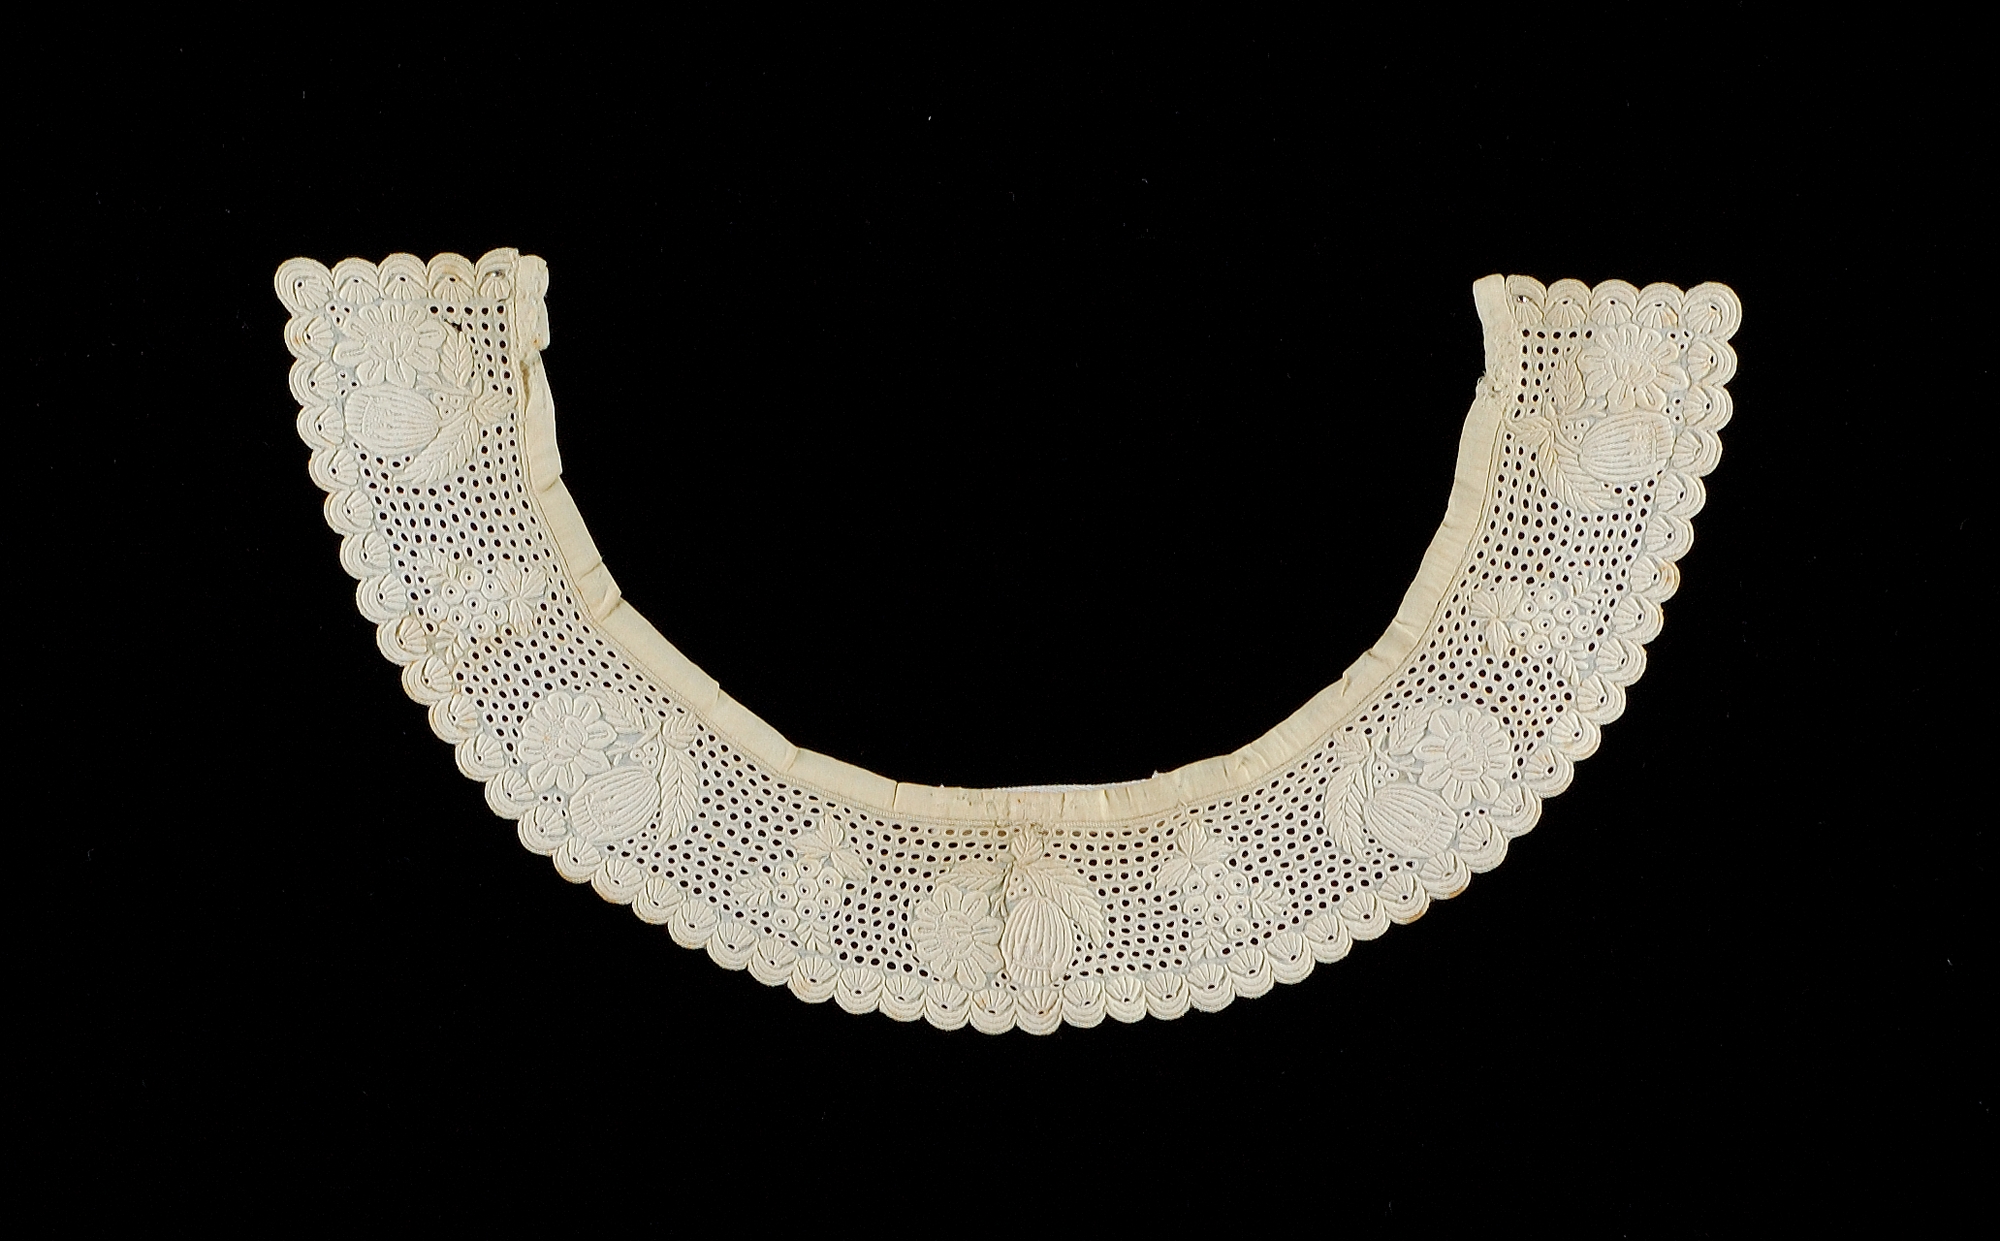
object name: collar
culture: american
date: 1850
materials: cotton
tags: flowers